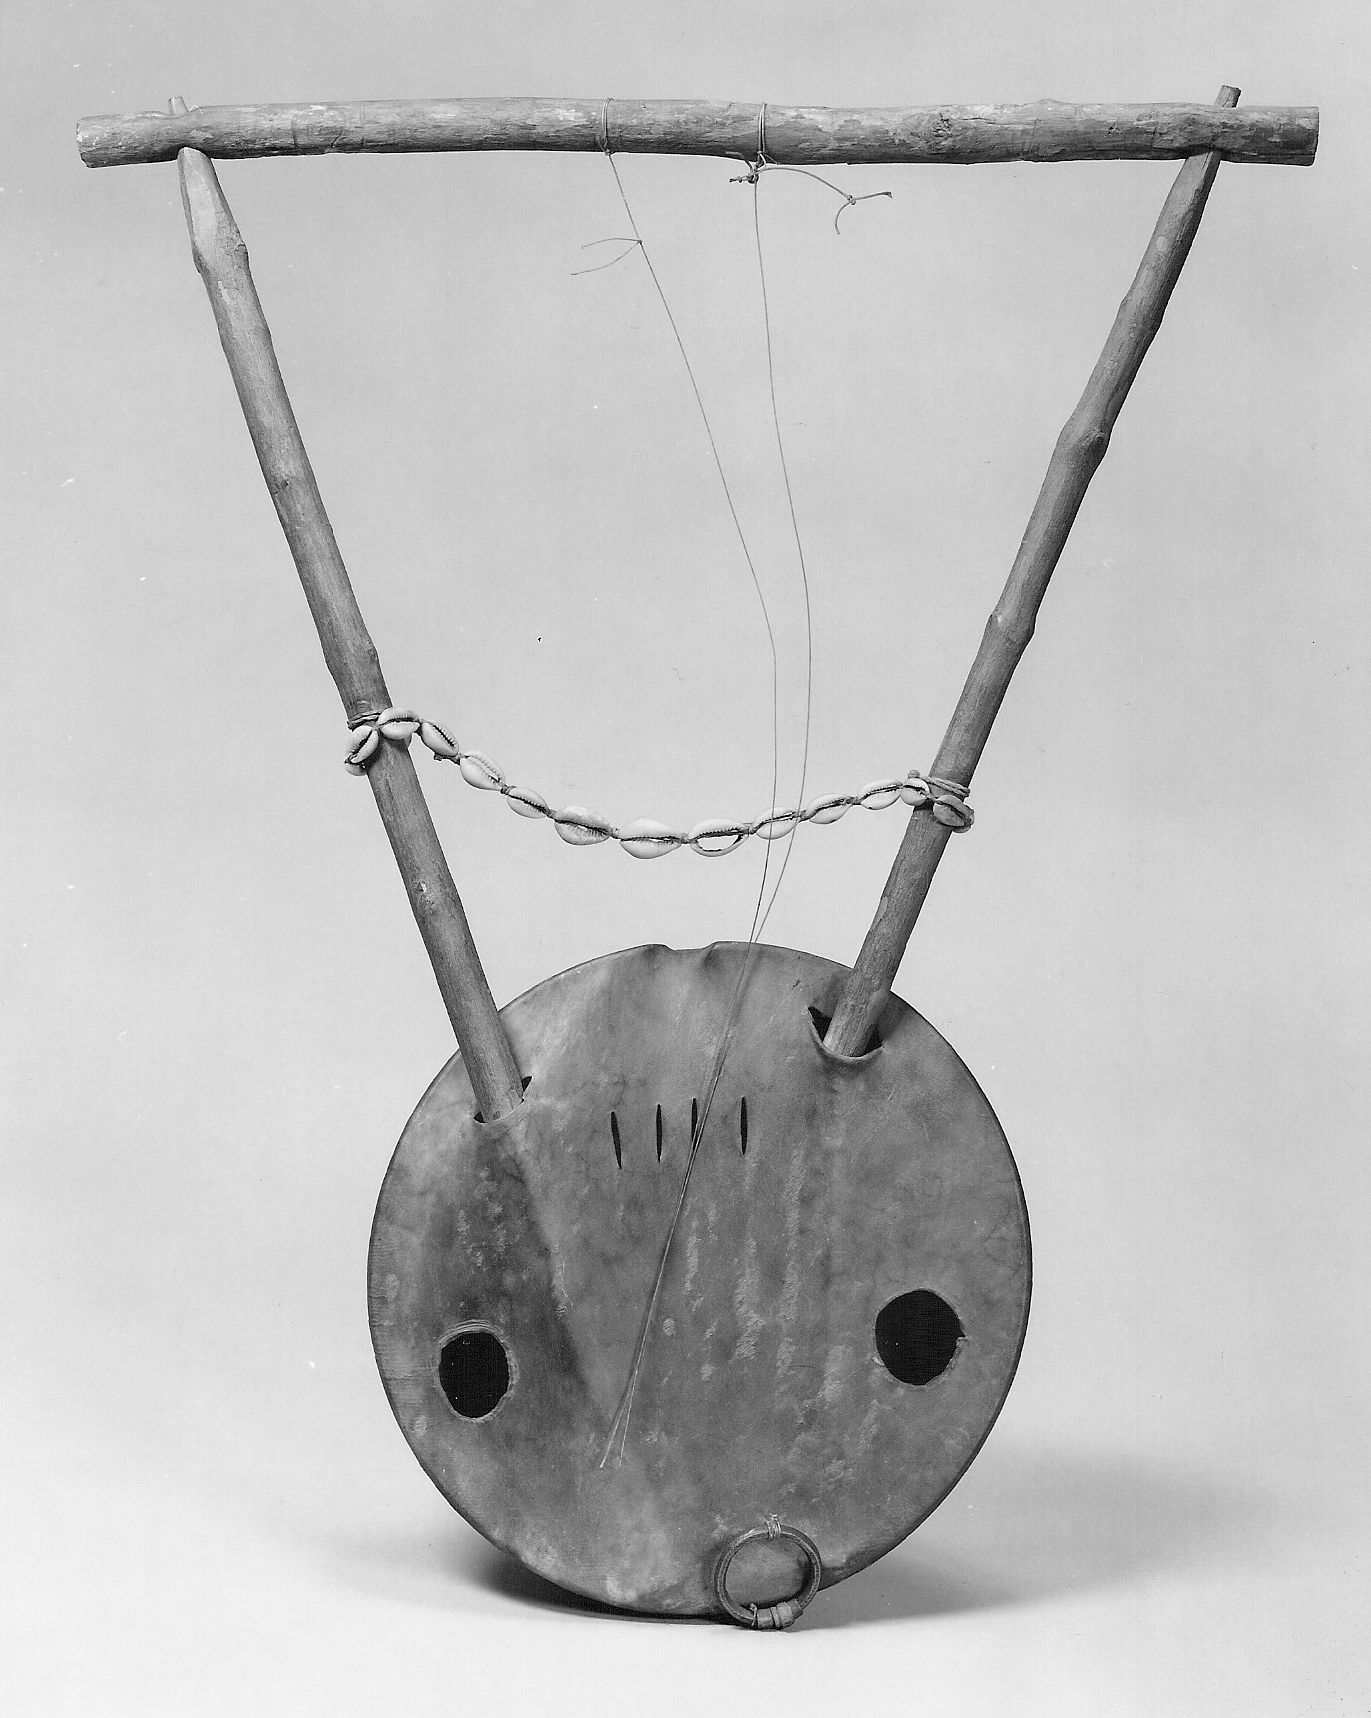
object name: lyre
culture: east african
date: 1801-1900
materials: skin, wood